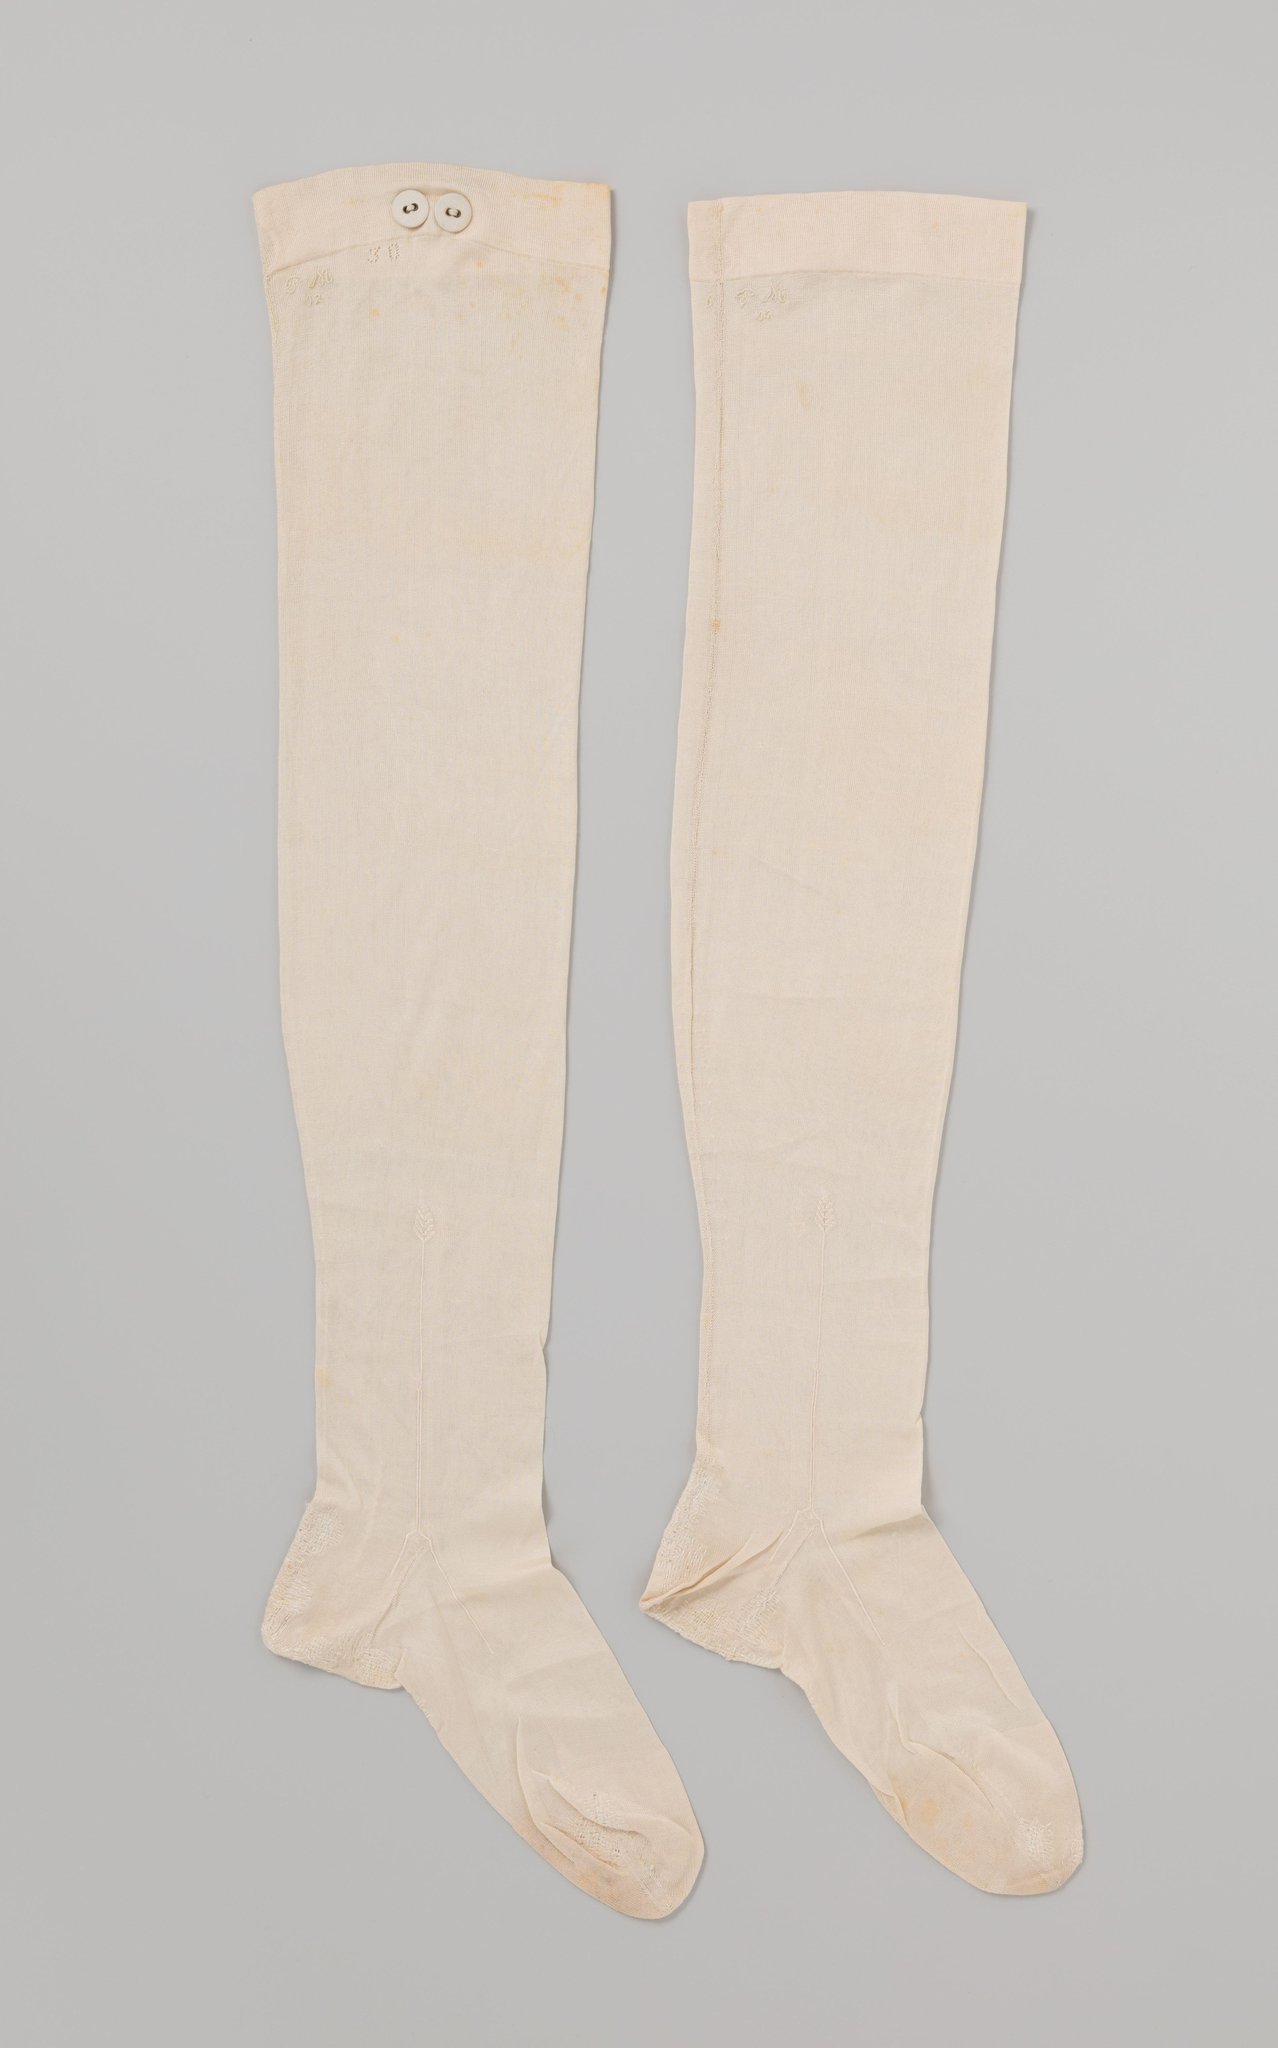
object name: clothing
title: Kous van effen crèmekleurige zijde, met een verticale streep uitlopend in een palmvorm op de klink, aan de boord twee knopen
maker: Anonymous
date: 1900-1910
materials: silk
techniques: embroidered, knitting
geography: paris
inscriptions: number: ‘'6'’, number: ‘'30'’, initials: ‘'PM' '12'’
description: Kous van effen crèmekleurige zijde, met een verticale streep uitlopend in een palmvorm op de klink, aan de boord twee stoffen knopen. Opschrift: 'PM', '12' en '6' en '30'.